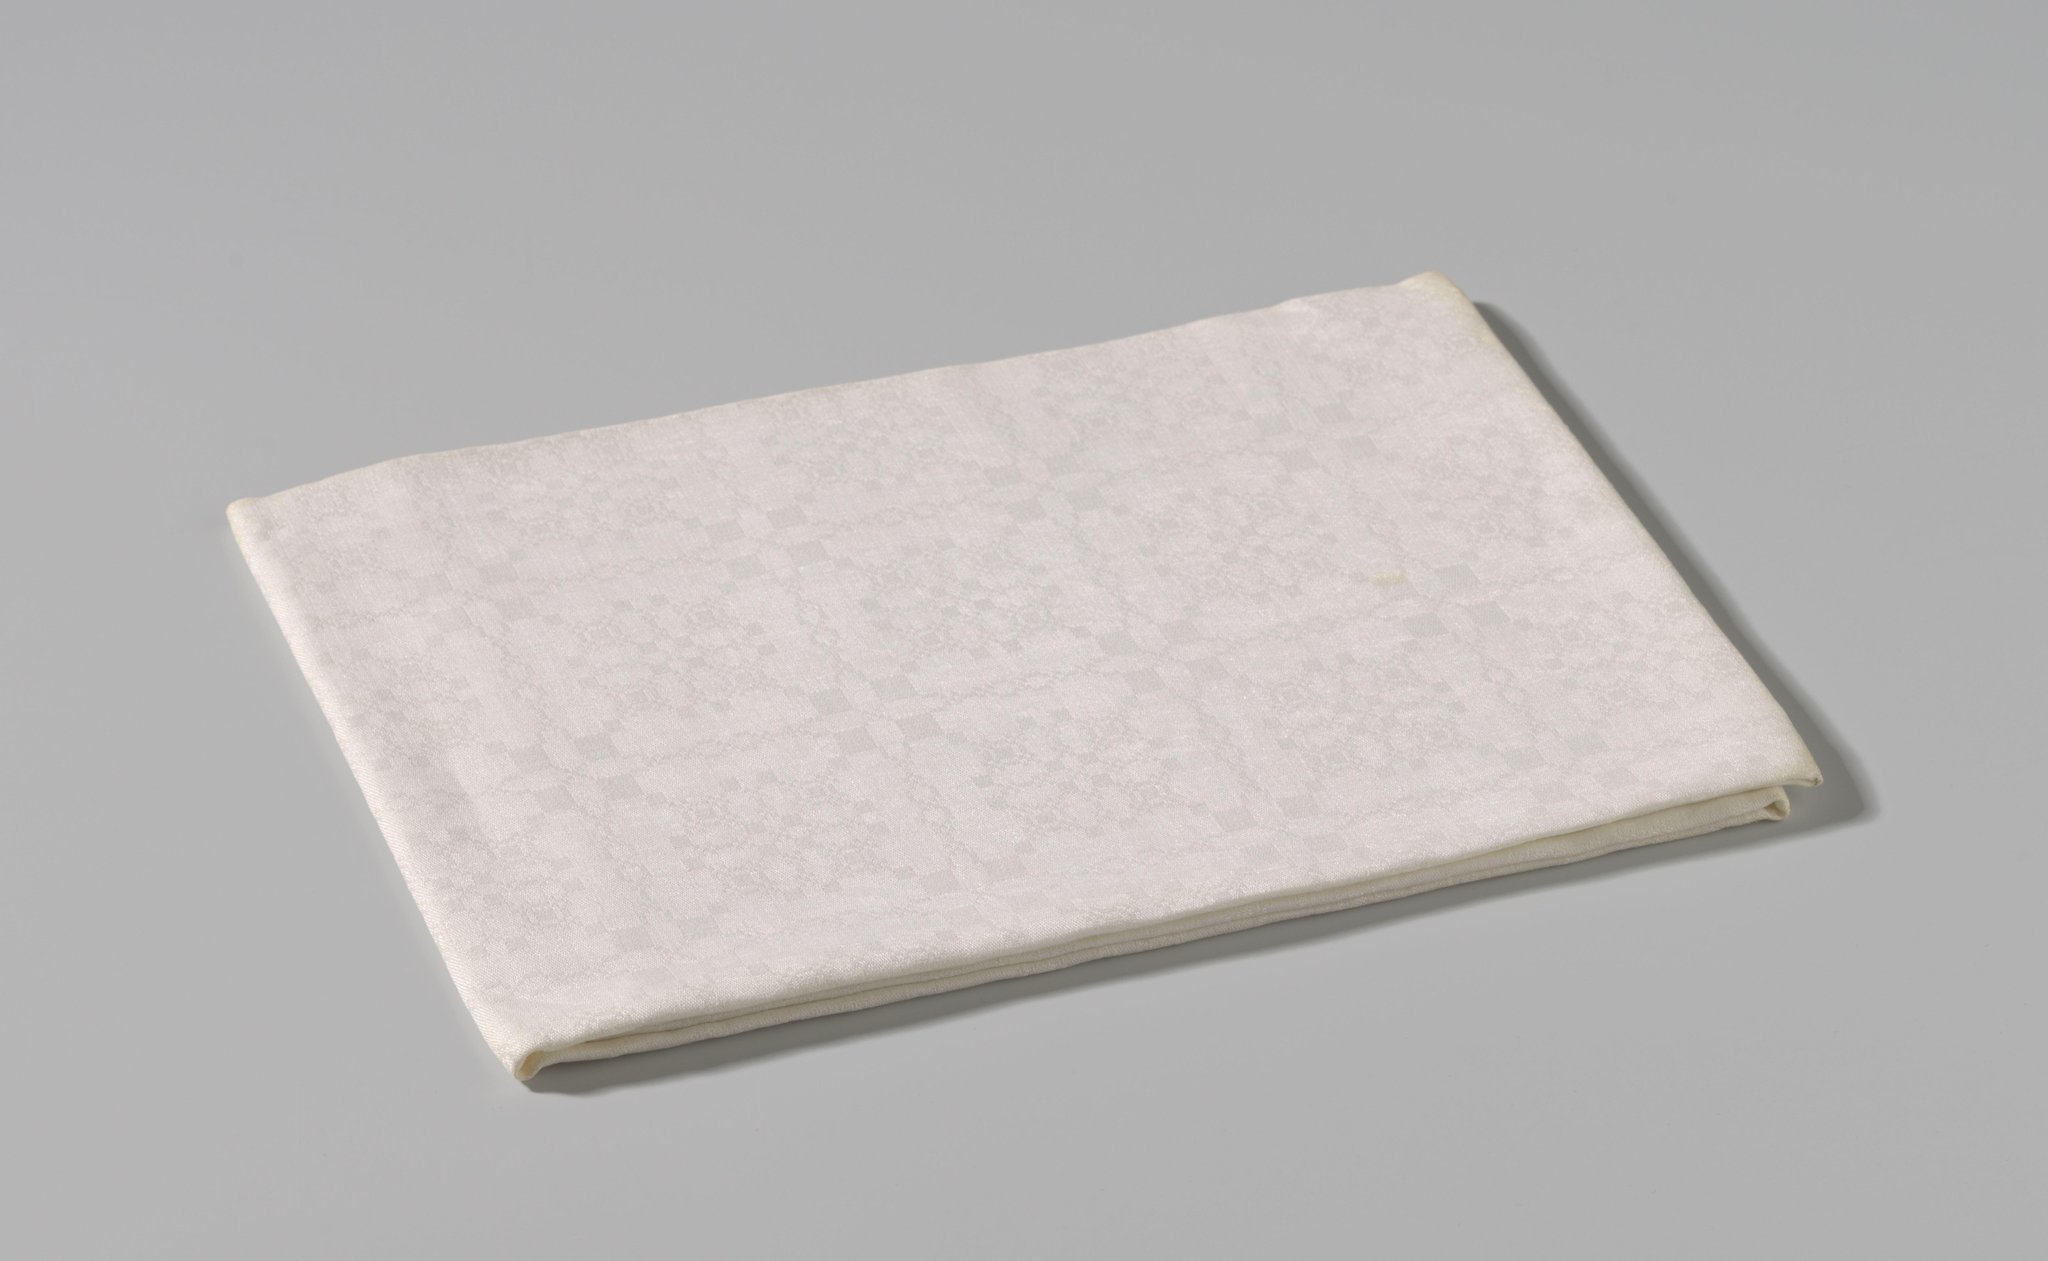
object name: napkin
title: Servet van wit linnen met pellenpatroon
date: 1720-1780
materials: linen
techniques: peeled fabric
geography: northern netherlands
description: Witlinnen servet met een pellenpatroon, gemerkt met kroon AVH 24.